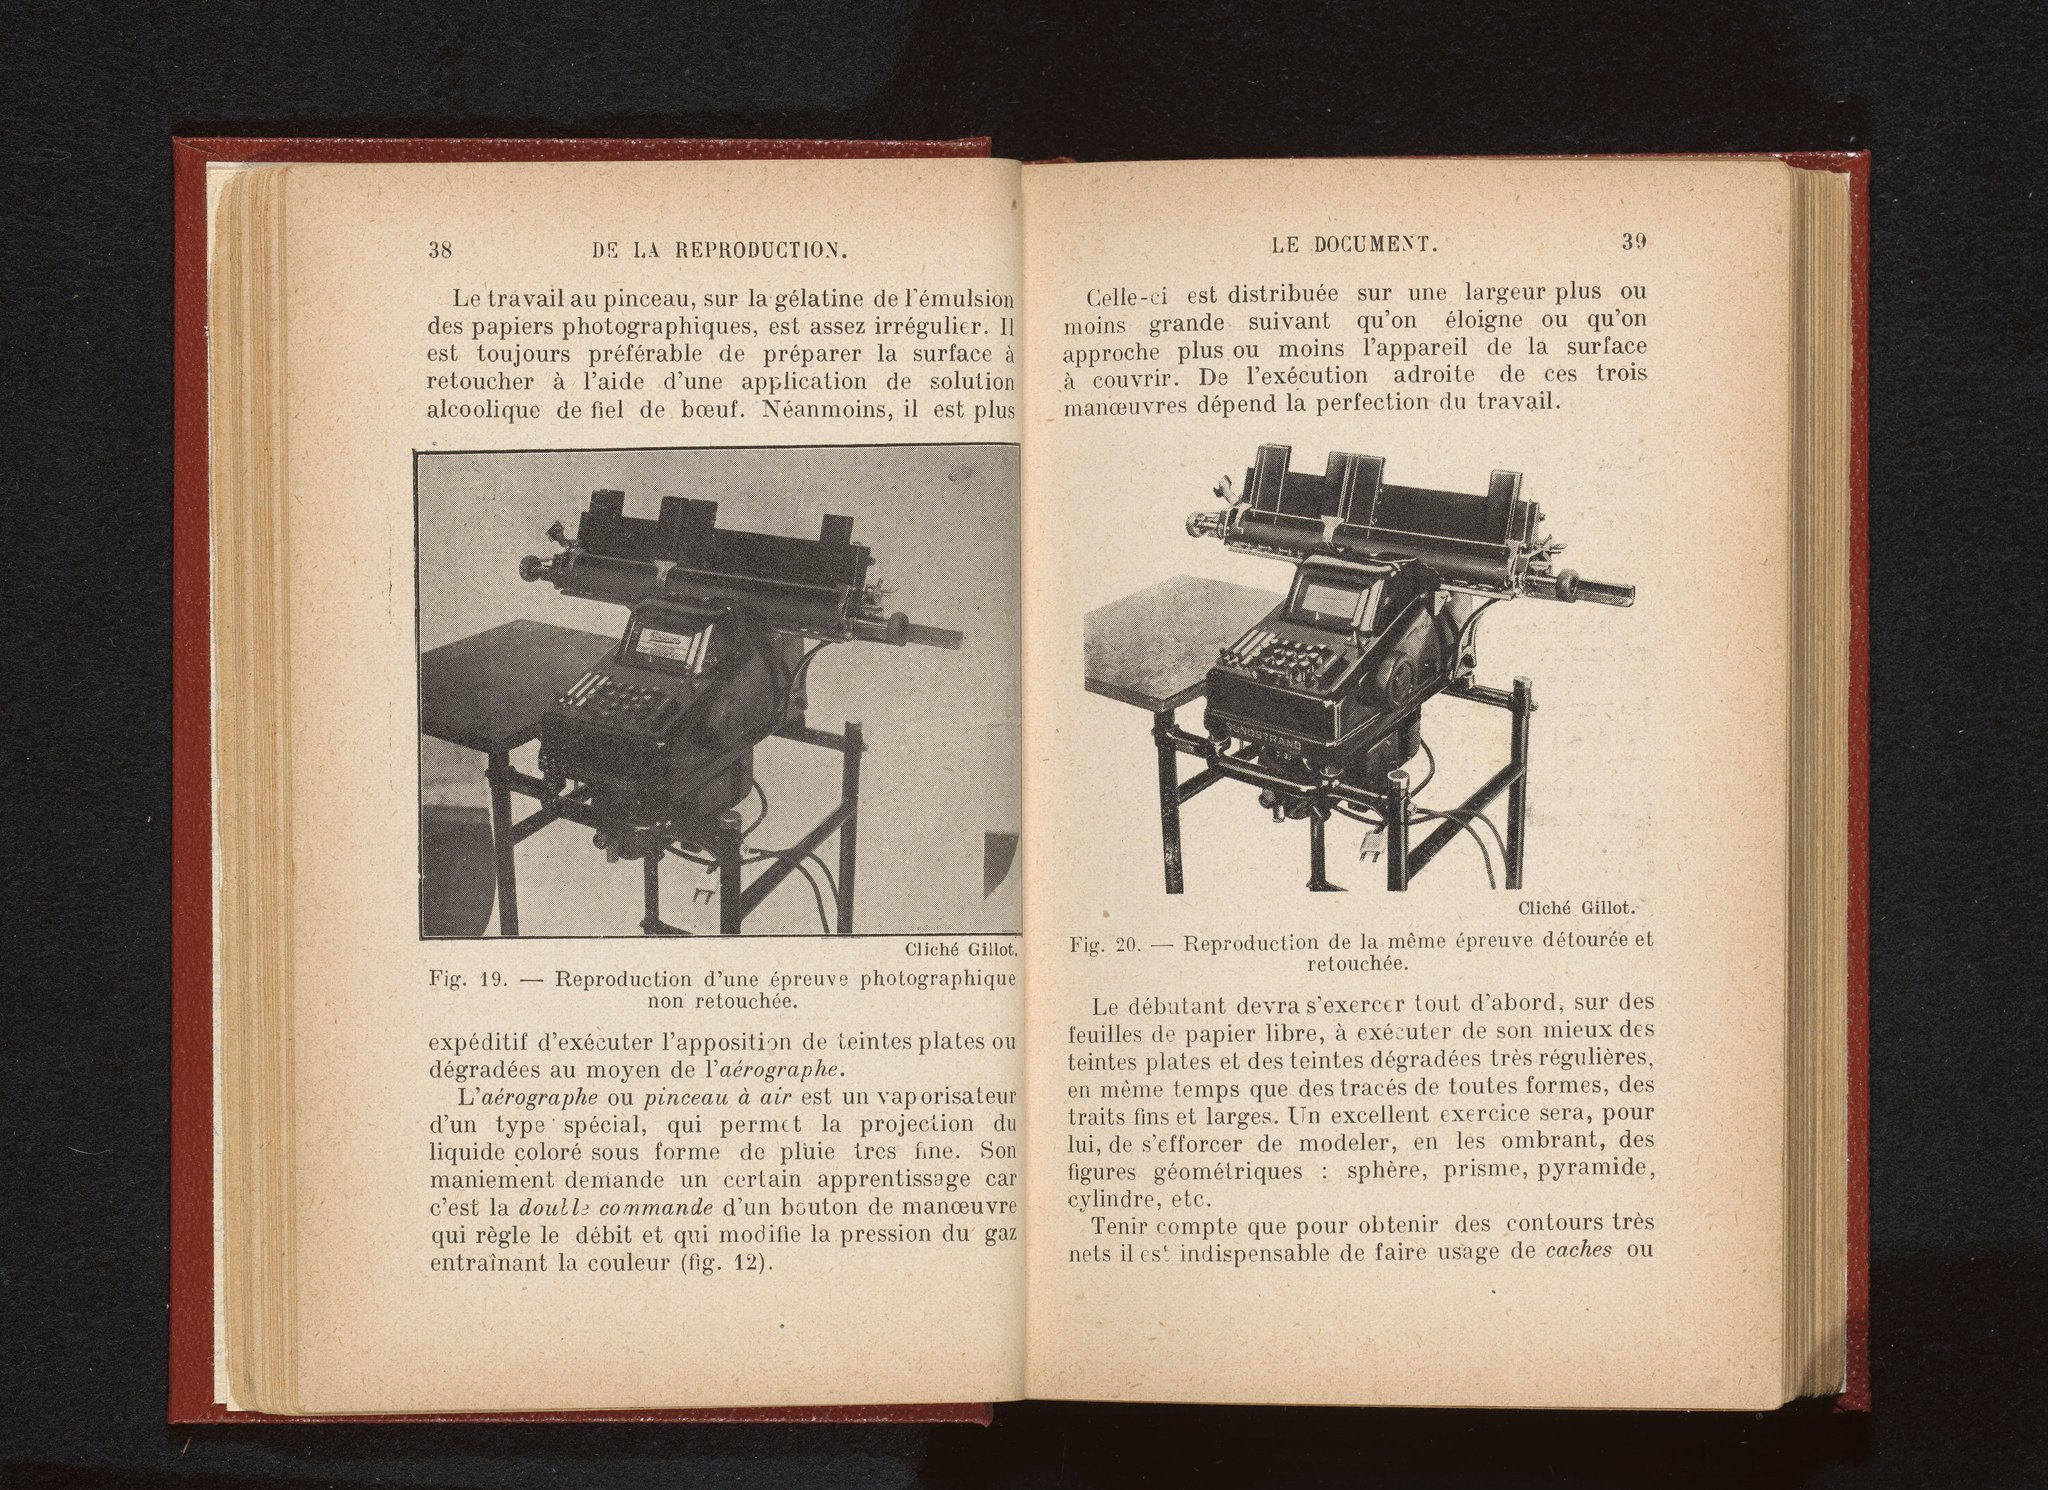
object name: photomechanical print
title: Apparaat voor vermoedelijk fotomechanische reproducties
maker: Anonymous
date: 1922-1932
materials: paper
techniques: autotype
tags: photographic apparatus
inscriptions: number: ‘Fig. 20.’